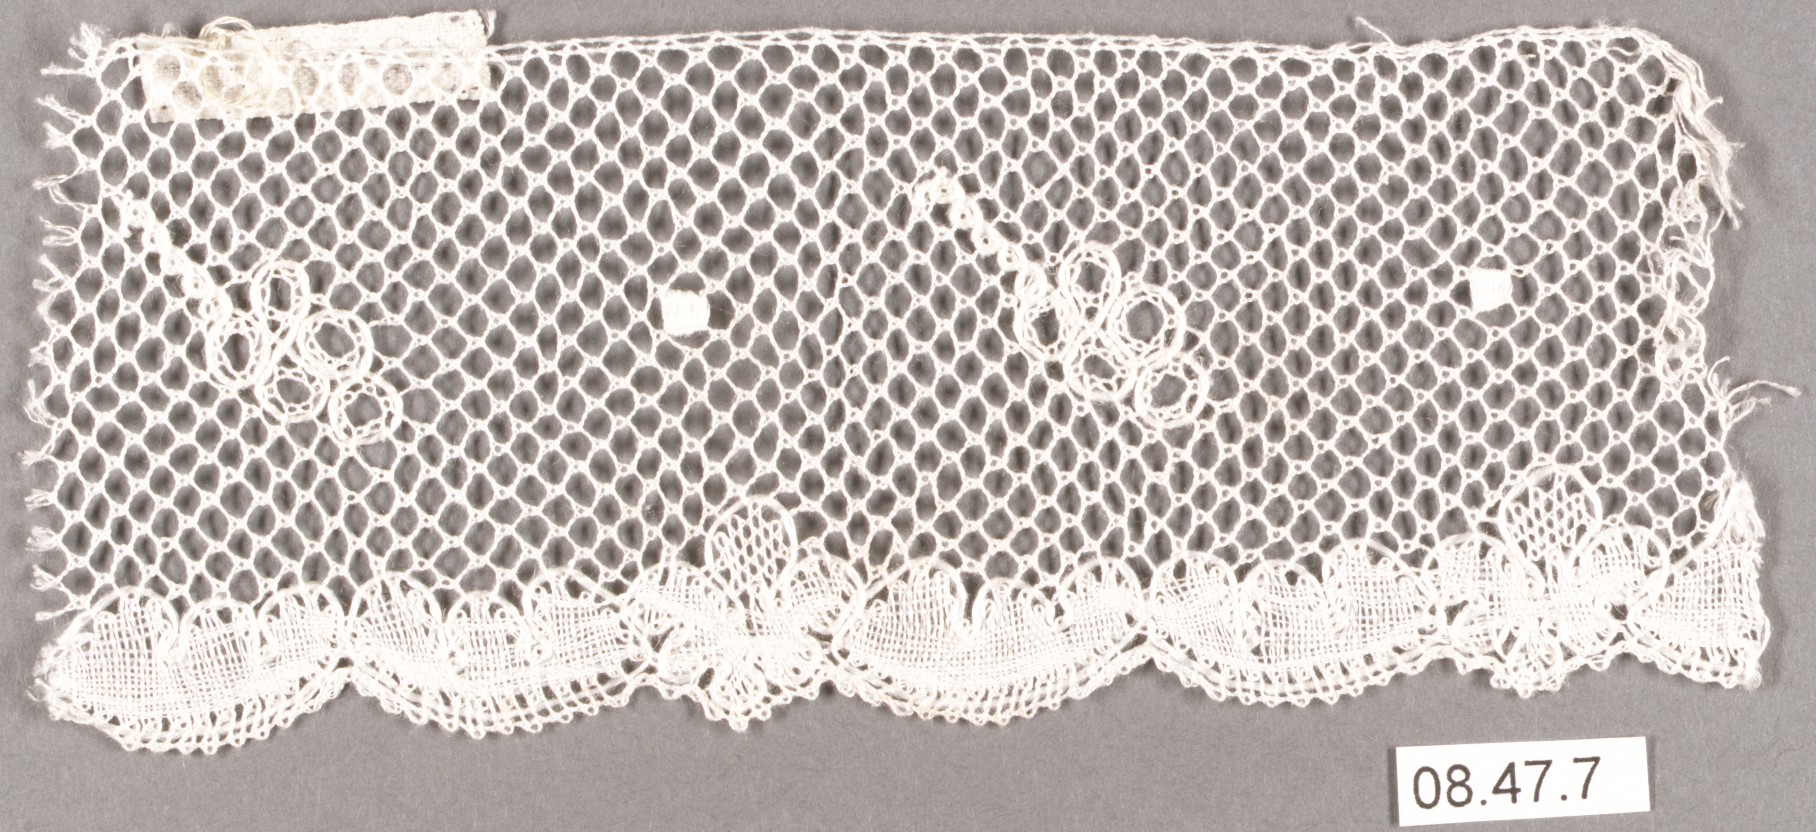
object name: fragment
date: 1801-1900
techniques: lace